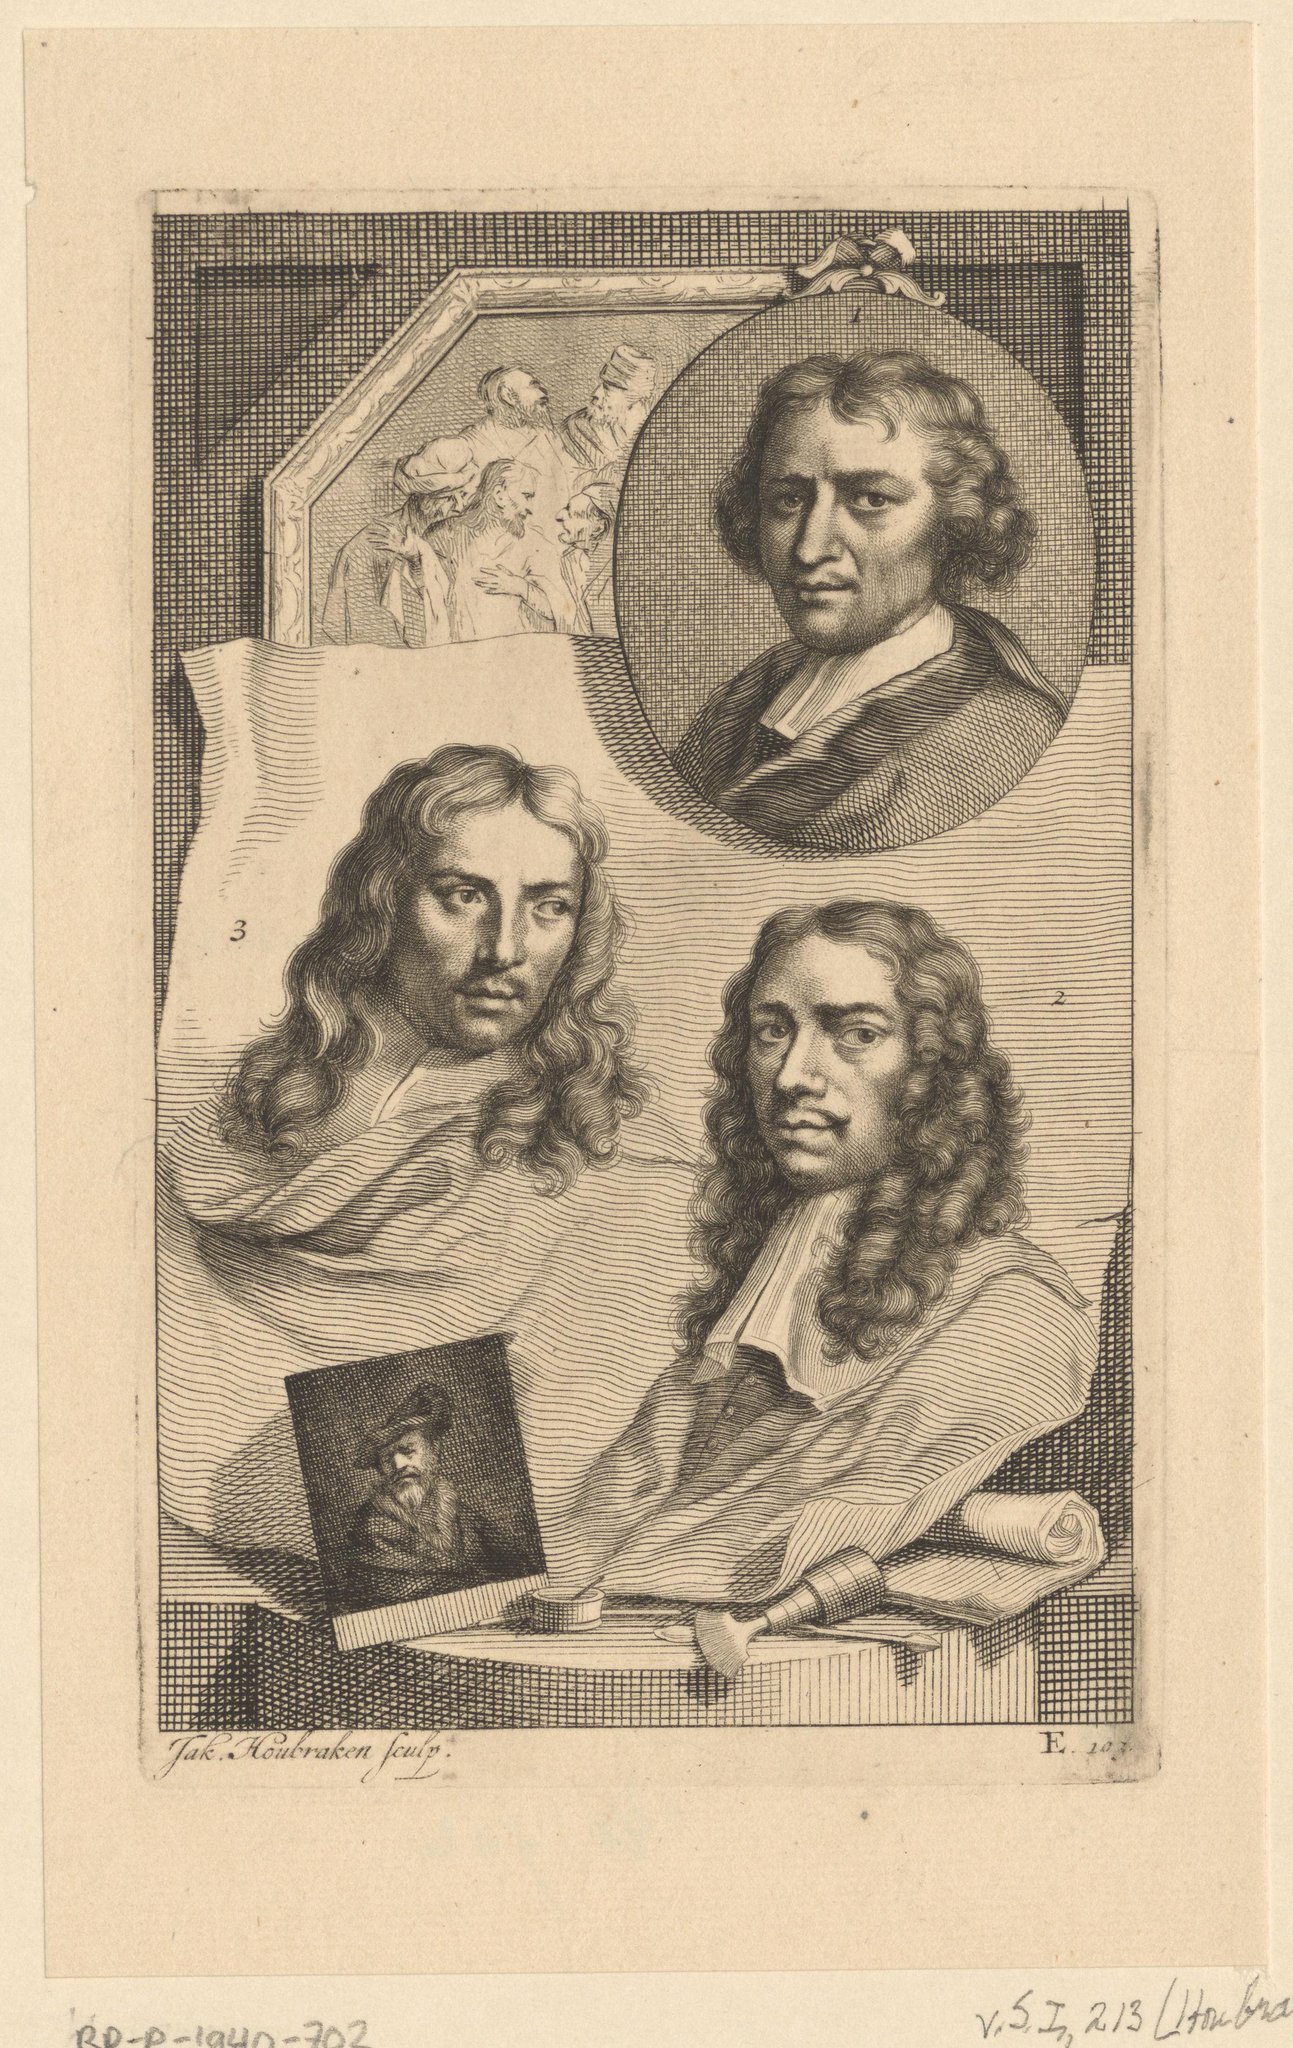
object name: book illustration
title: Portretten van Gerbrand van den Eeckhout, Wallerant Vaillant en Jacques Vaillant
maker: jacob houbraken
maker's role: draughtsman, print maker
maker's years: 1698-1780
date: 1719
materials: paper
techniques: engraving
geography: amsterdam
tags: lille, wallerant vaillant, print maker, gerbrand van den eeckhout, amsterdam, berlin, painter, jacques vaillant, historical persons, tools, implements of graphic artist, portrait, self-portrait of artist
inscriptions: collector's mark: Lugt 2760, collector's mark: Lugt 2228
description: Prent waarschijnlijk uit: Houbraken, Arnold. De groote schouburgh der Nederlantsche konstschilders en schilderessen (...). Amsterdam: Arnold Houbraken, 1719, dl. 2. Latere staat gebruikt in editie van dit werk uit 1753. Tweede staat gebruikt in publicatie uit 1729.